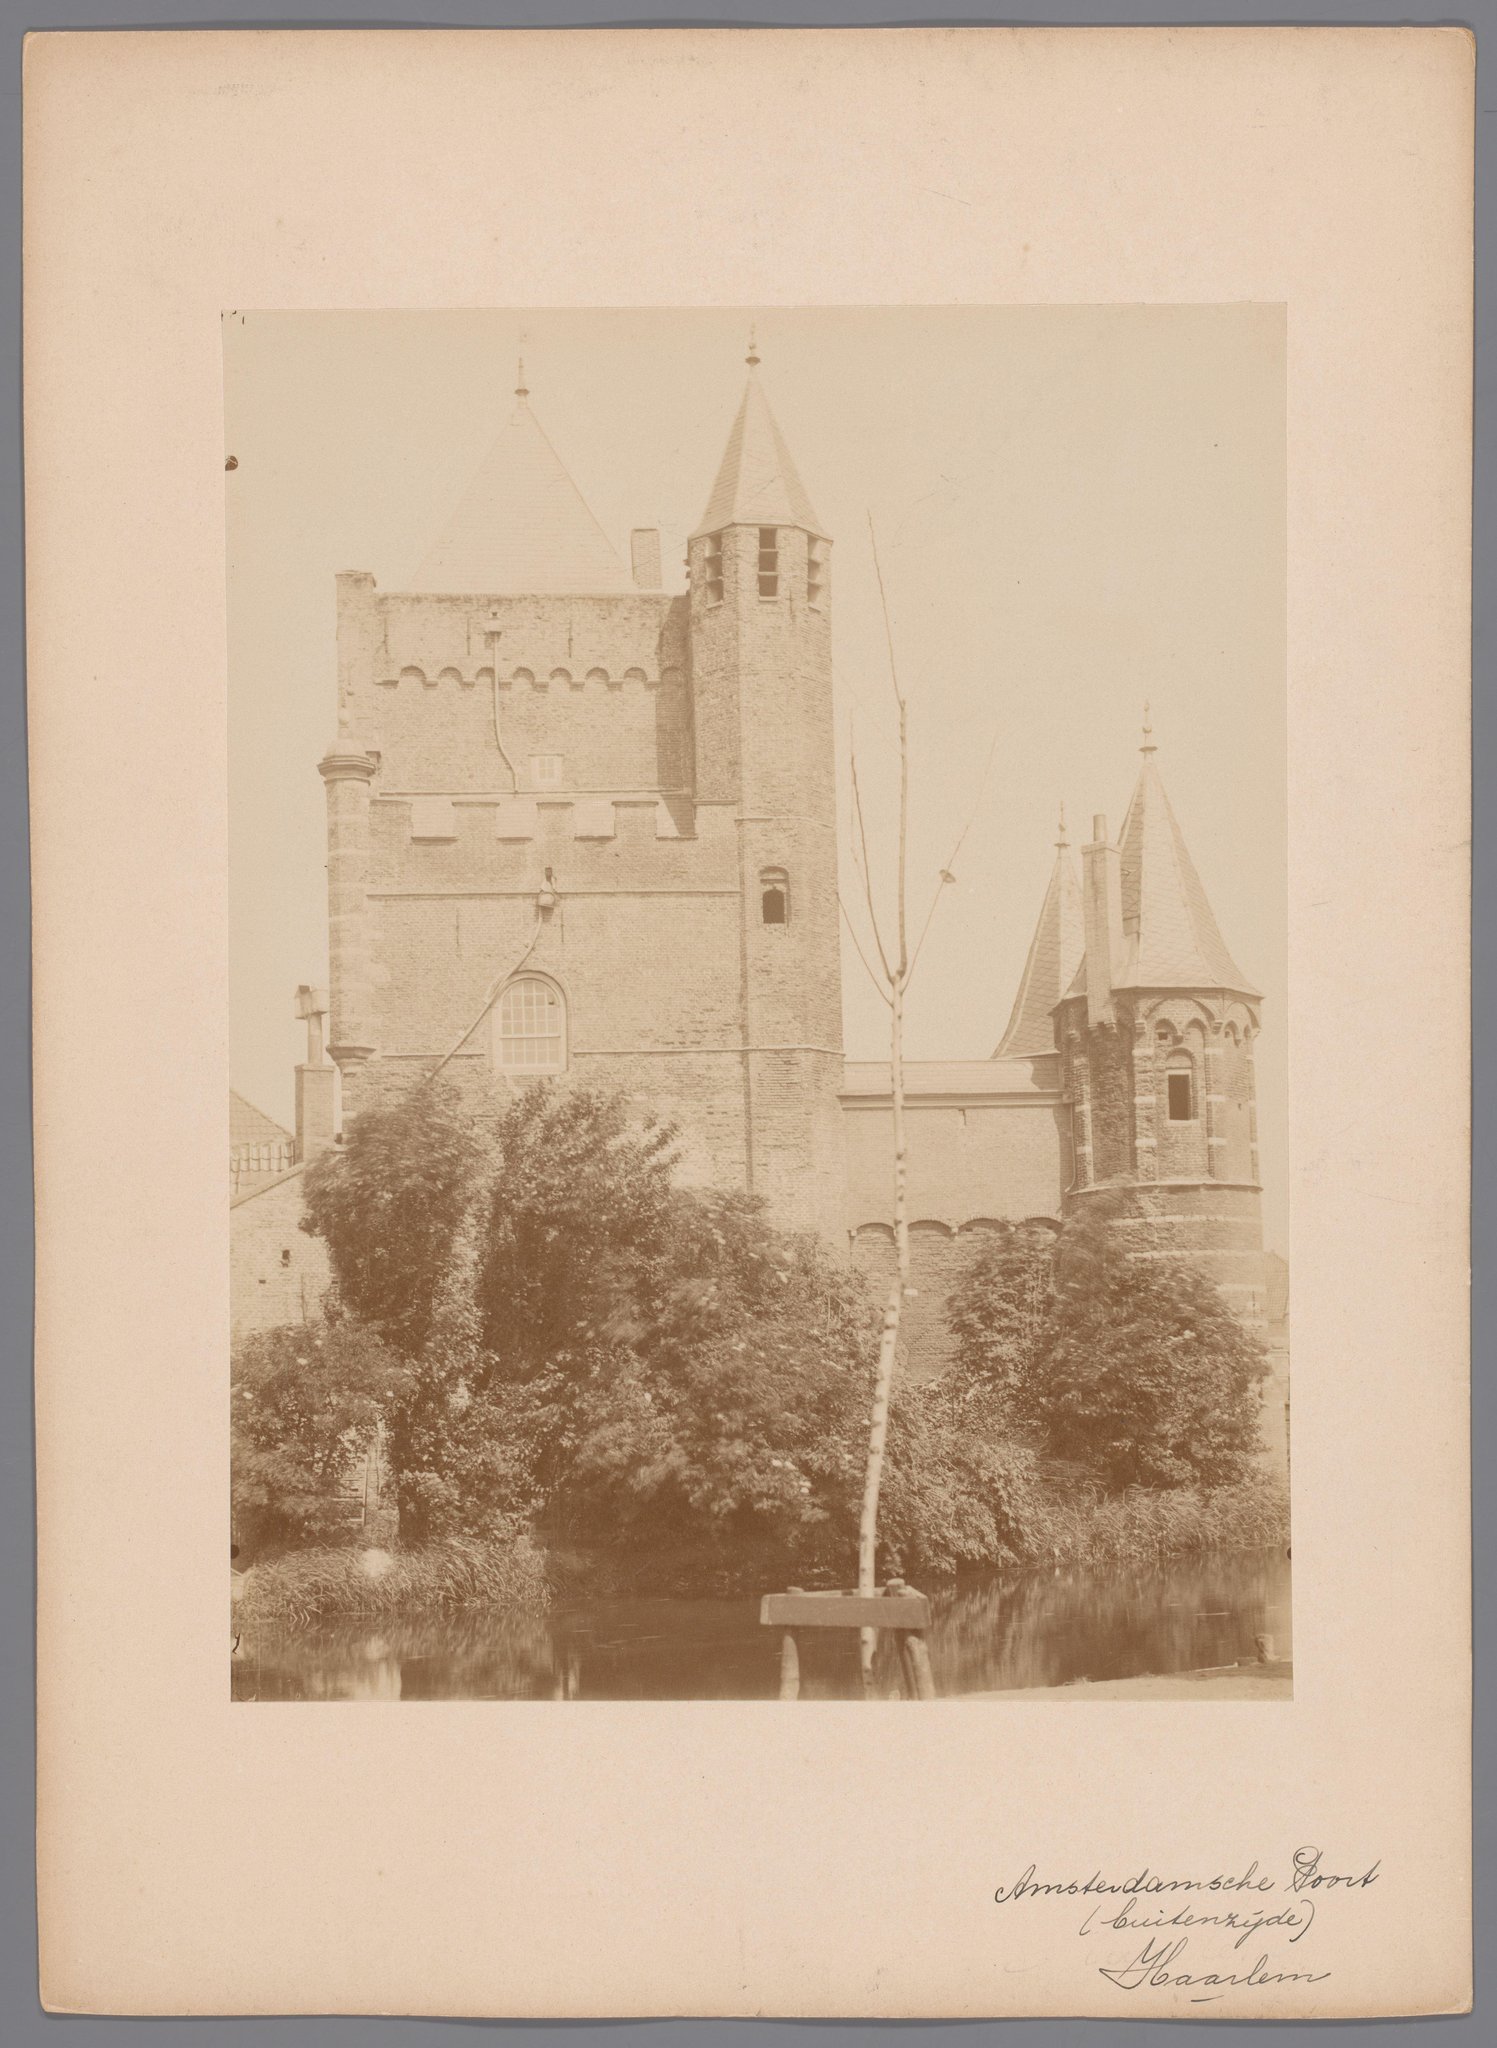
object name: photograph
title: Gezicht op de Amsterdamse Poort te Haarlem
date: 1890-1910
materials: cardboard, photographic support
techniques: albumen print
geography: haarlem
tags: gate, entrance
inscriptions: annotation: ‘Amsterdamsche Poort te Haarlem (buiten)’, annotation: ‘Amsterdamsche Poort (buitenzijde)/ Haarlem’